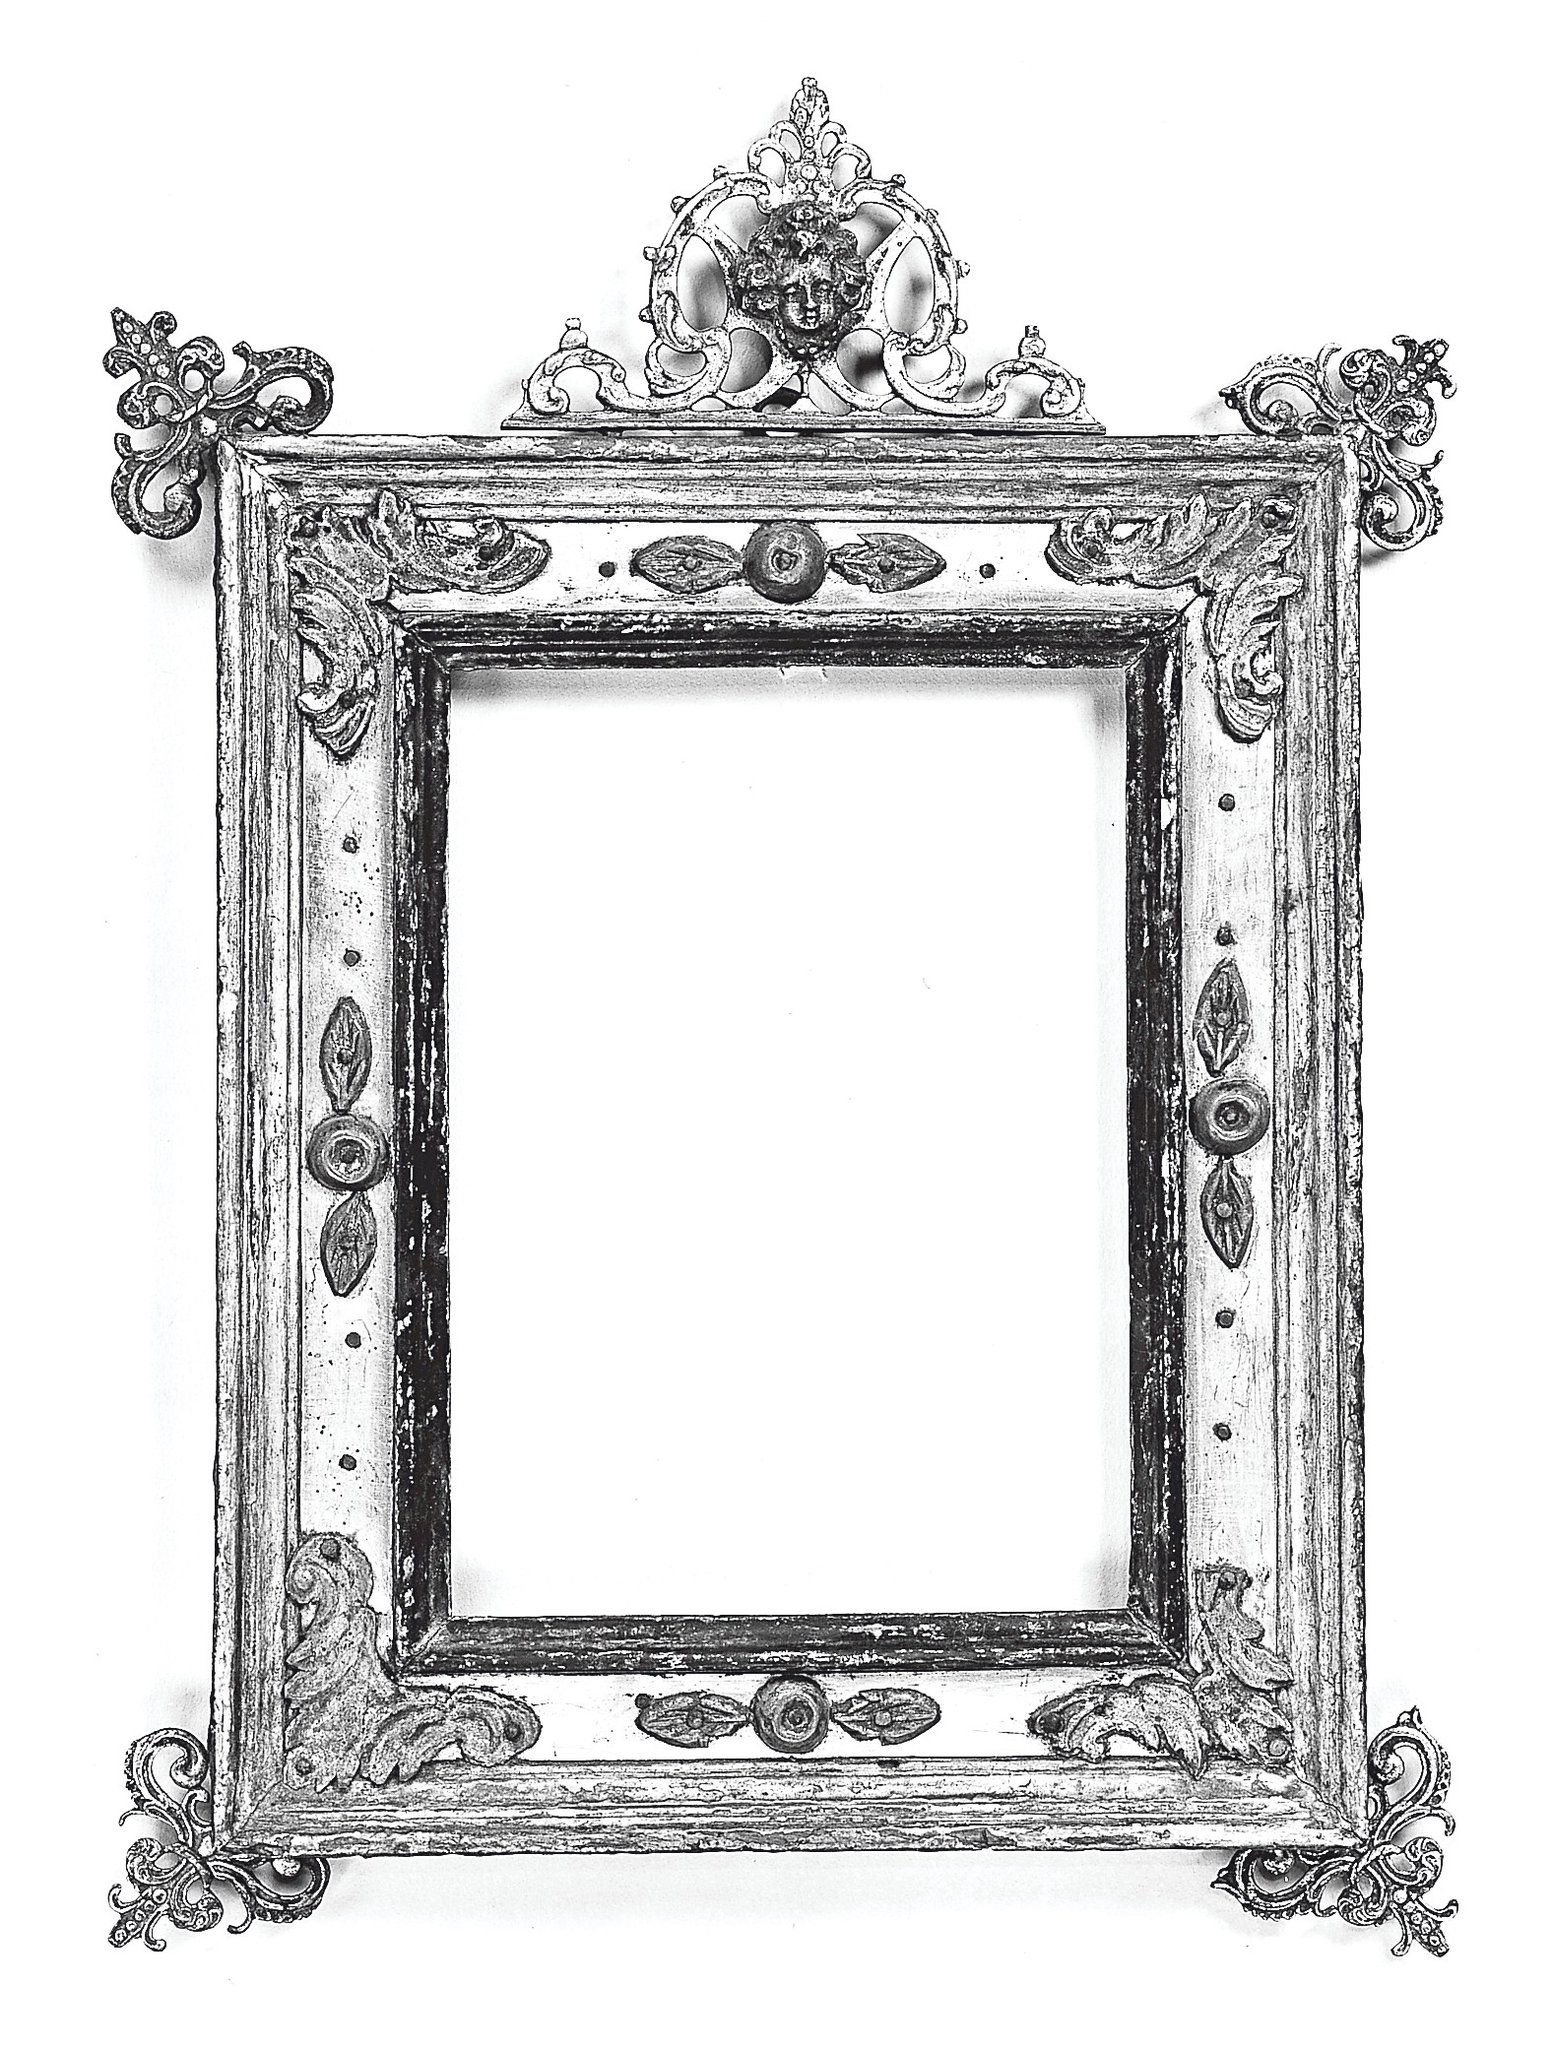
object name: frame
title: Cassetta frame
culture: italian, lombardy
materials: brass, wood, silver, tin